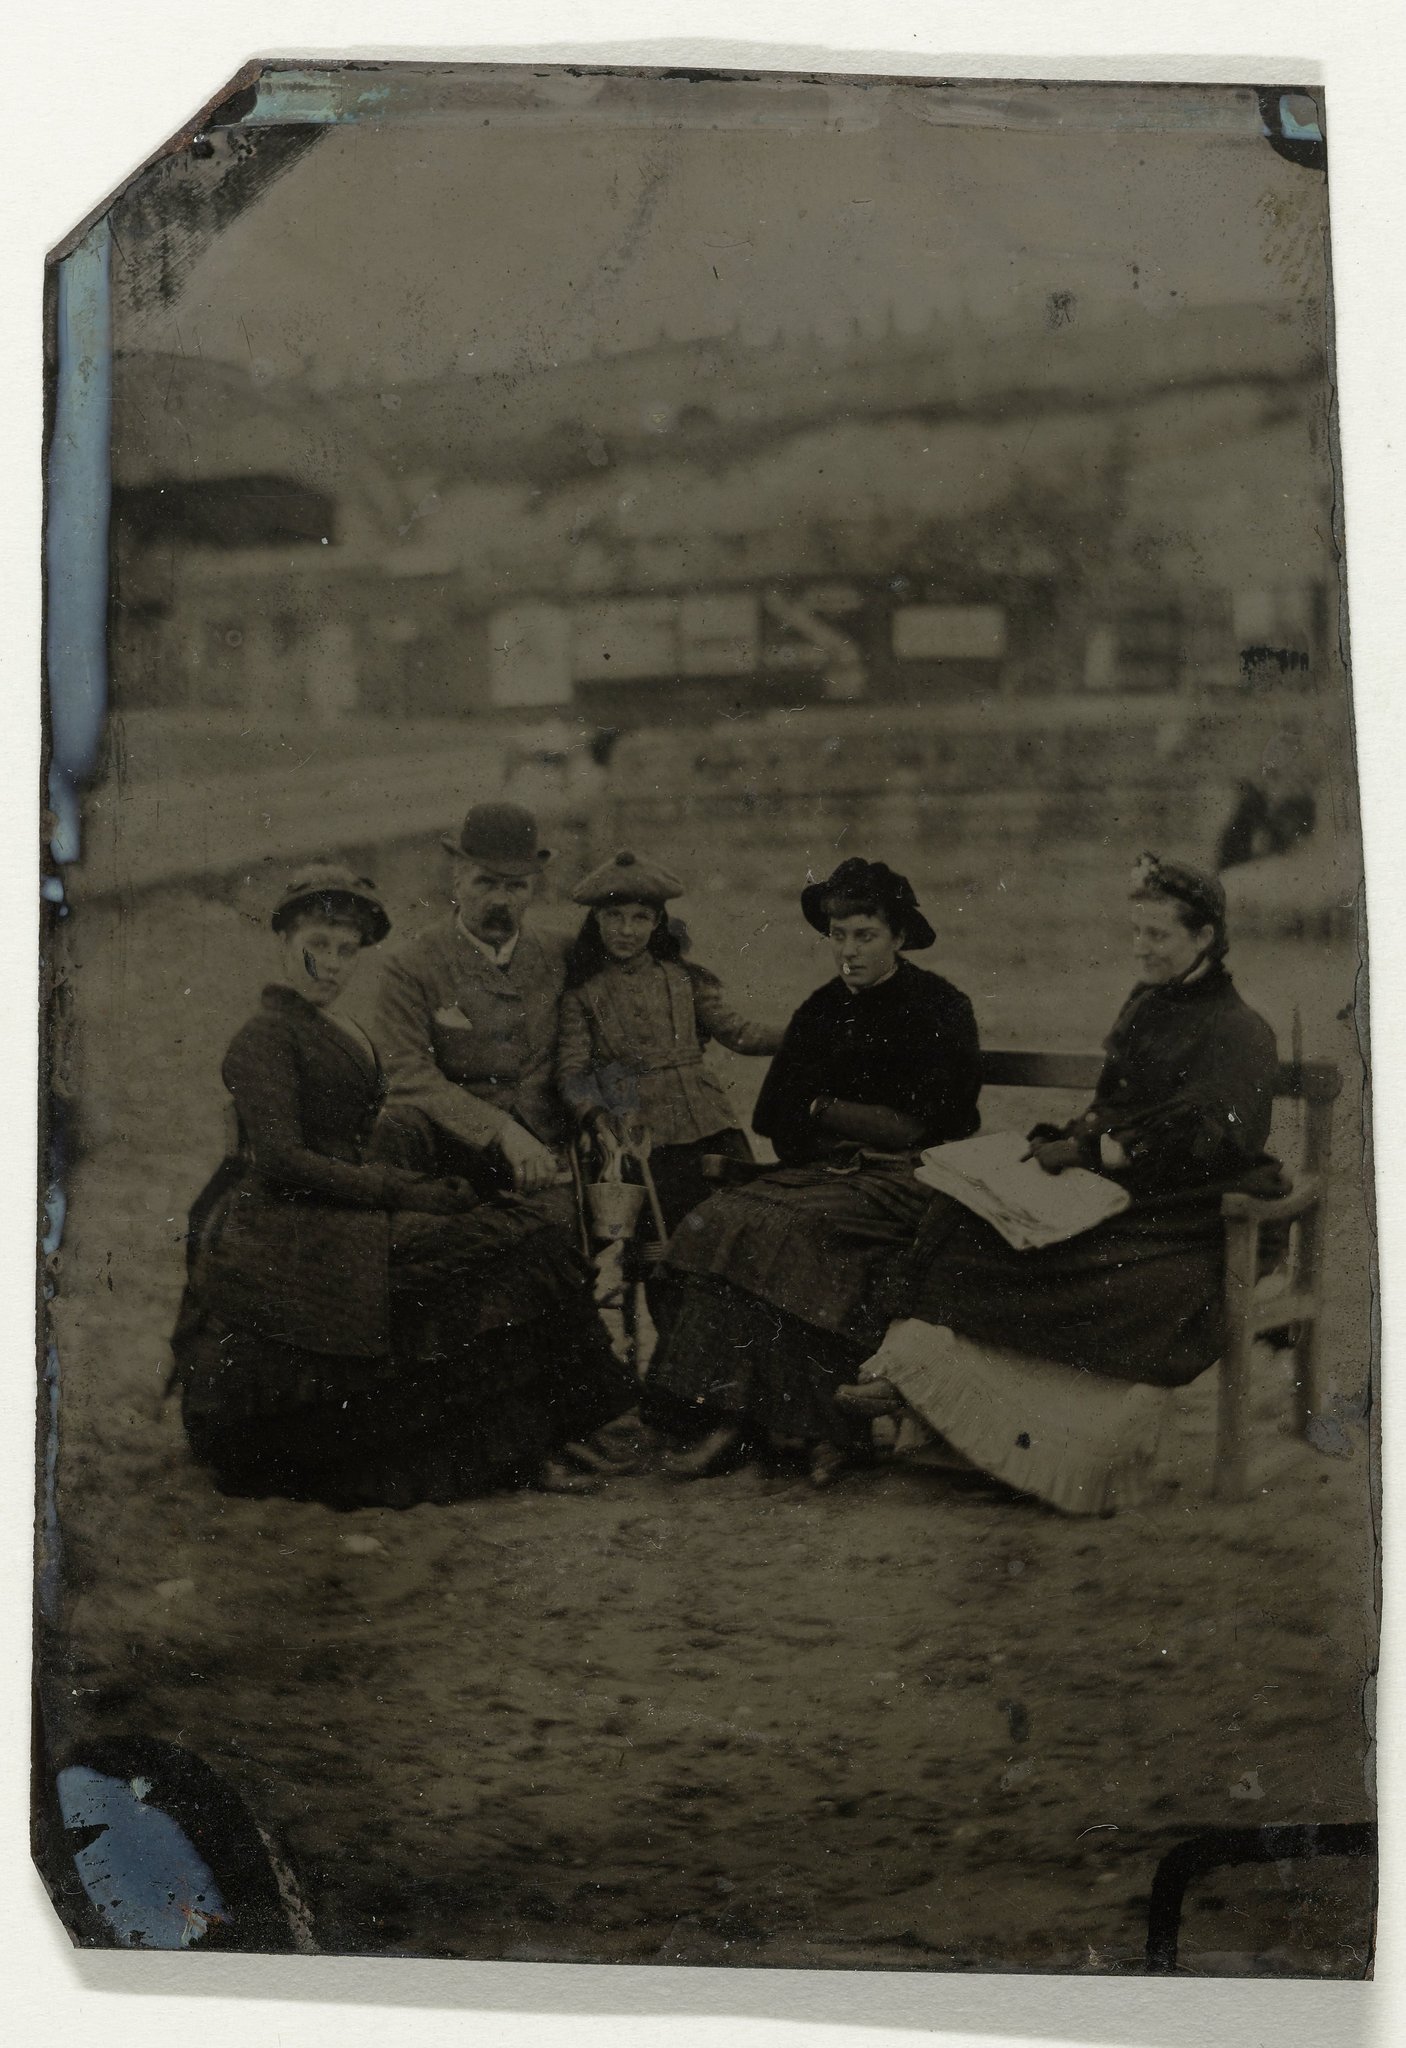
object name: photograph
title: Drie vrouwen, een man en een meisje op het strand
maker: Anonymous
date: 1880-1910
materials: metal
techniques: ferrotyping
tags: beach (as place of recreation)